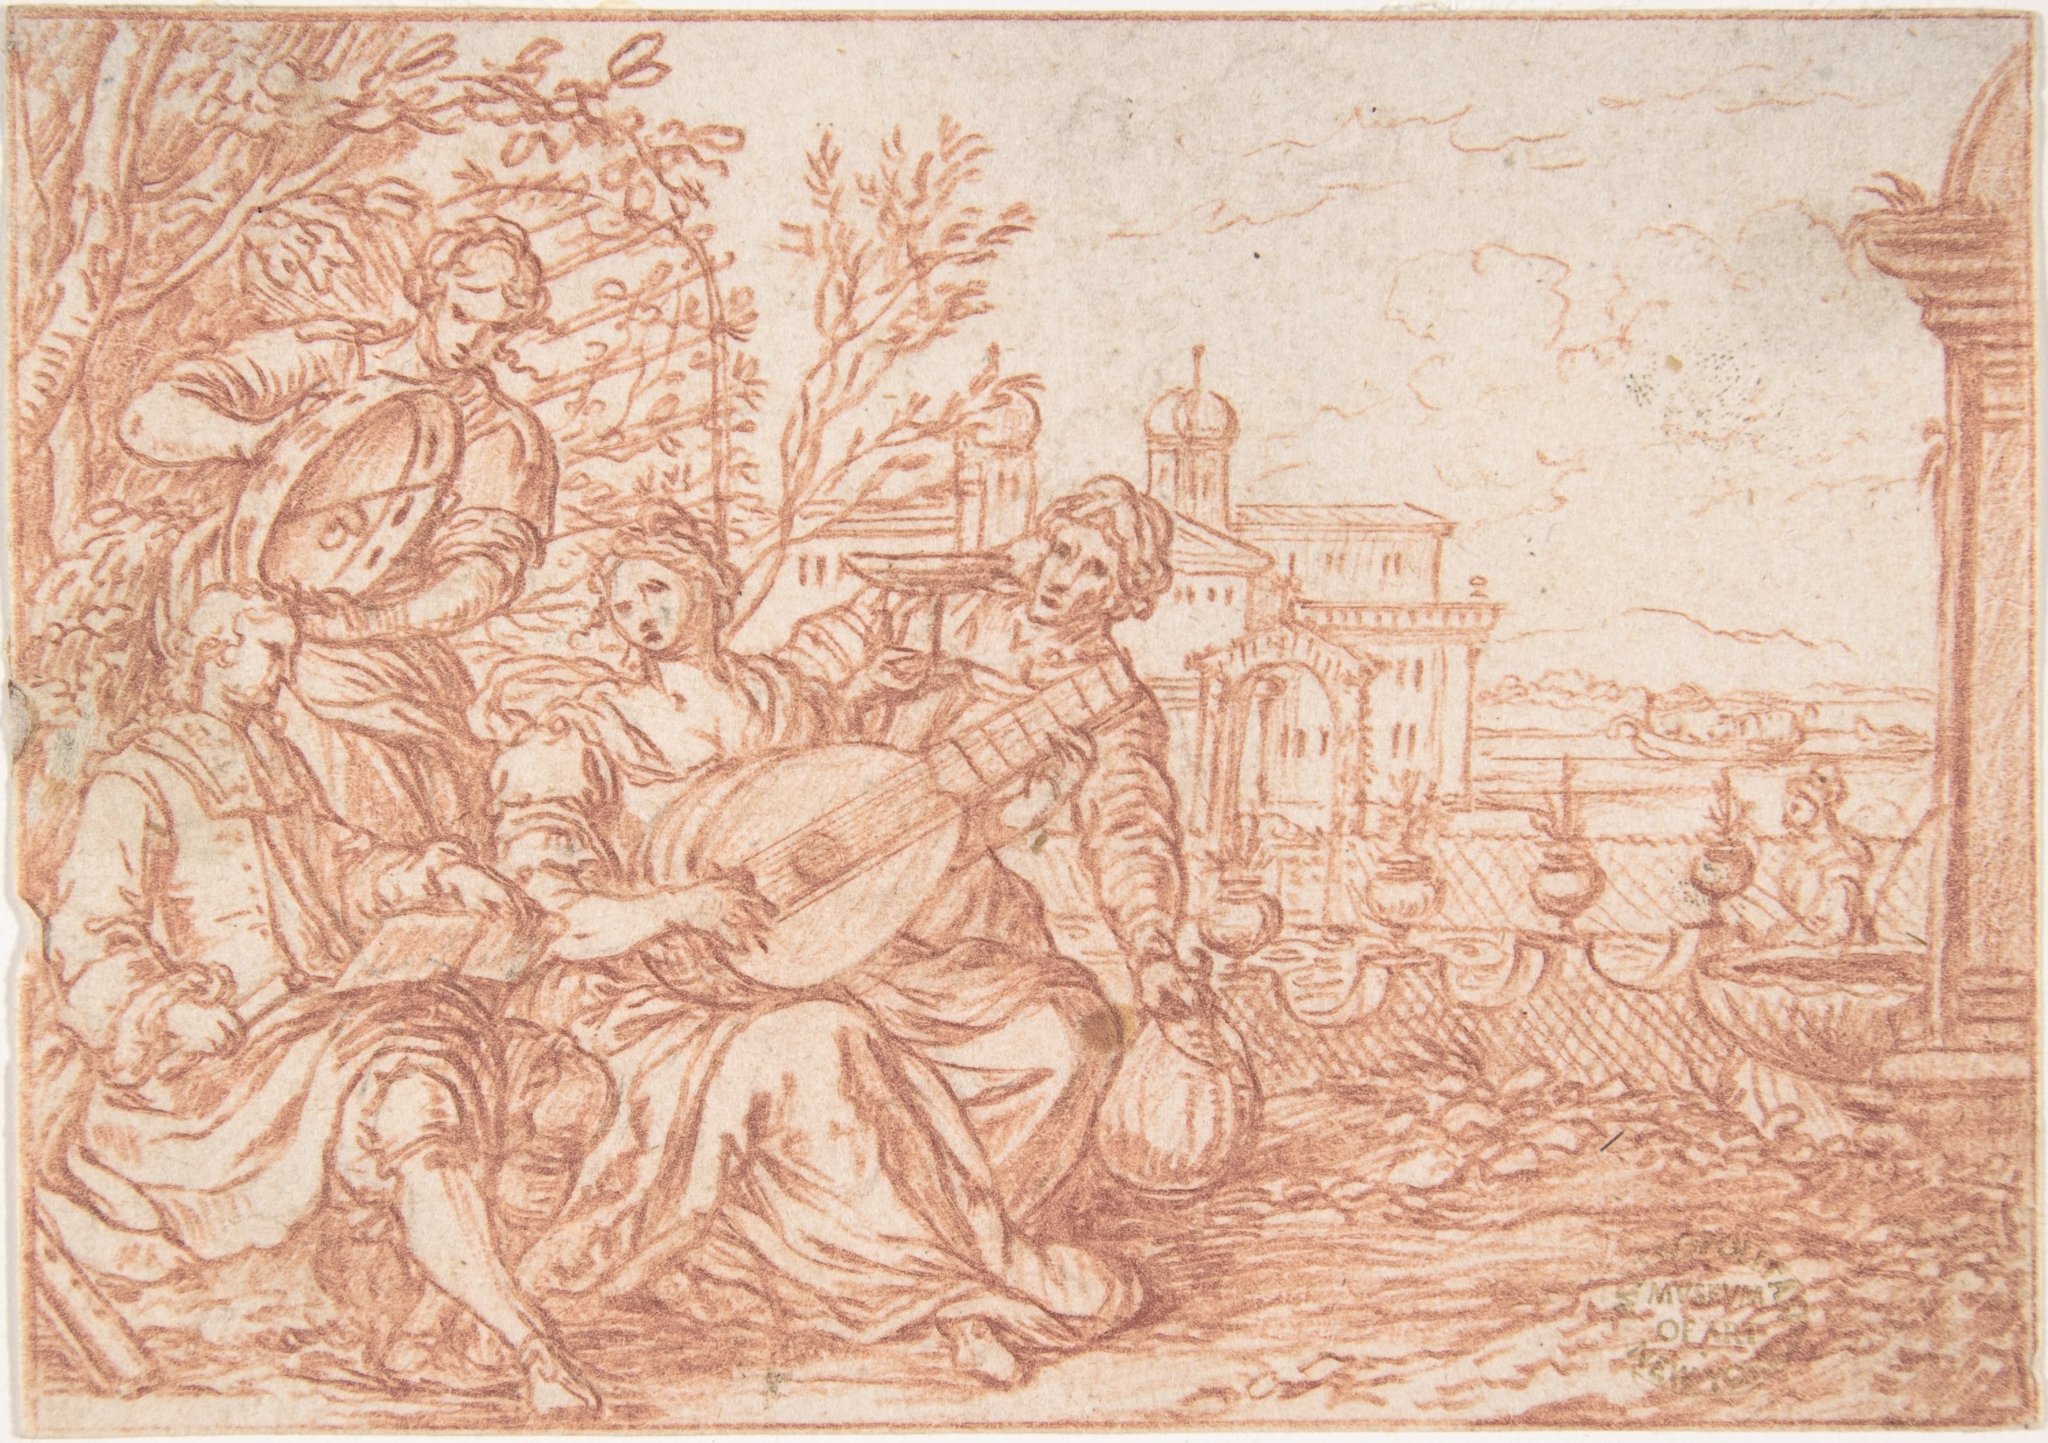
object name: drawing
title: May (one of a series representing the labors of the months)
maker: jonas umbach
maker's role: artist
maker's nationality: german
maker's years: 1624-1693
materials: chalk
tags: musical instruments,men,women,music